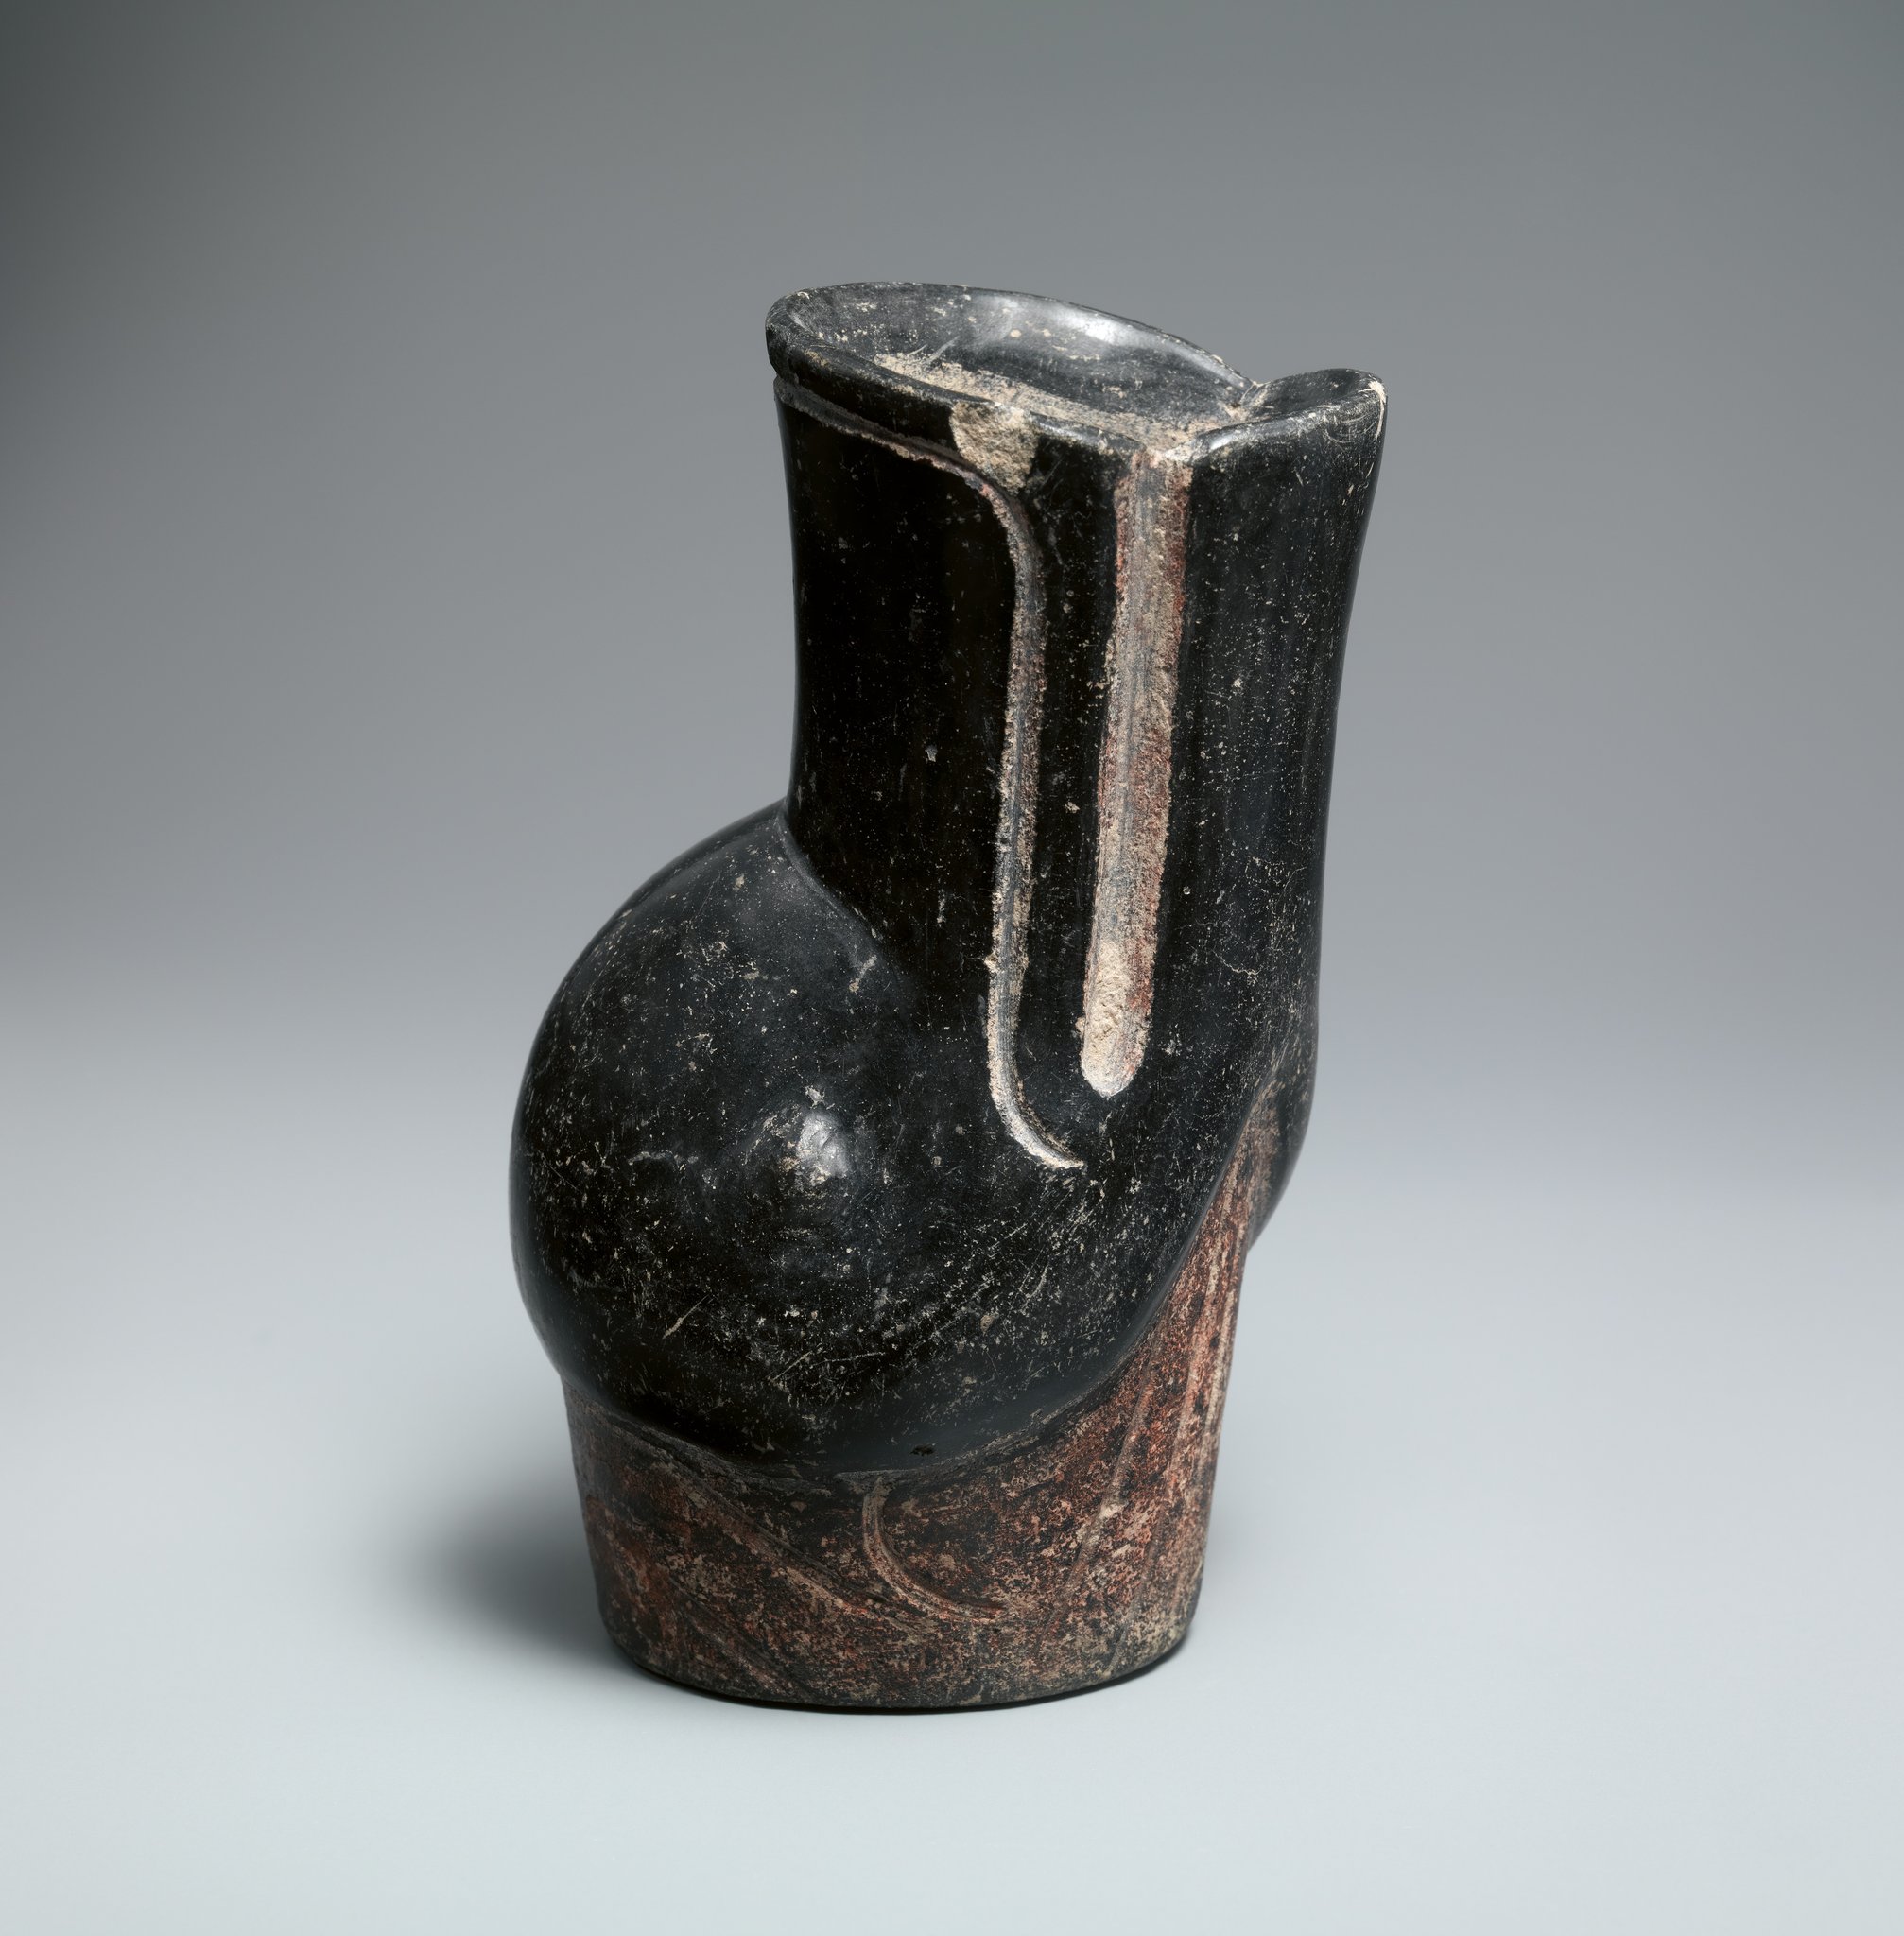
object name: vessel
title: Duck head vessel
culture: olmec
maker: olmec artist(s)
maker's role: artist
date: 1200-900 BCE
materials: ceramic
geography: mexico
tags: ducks